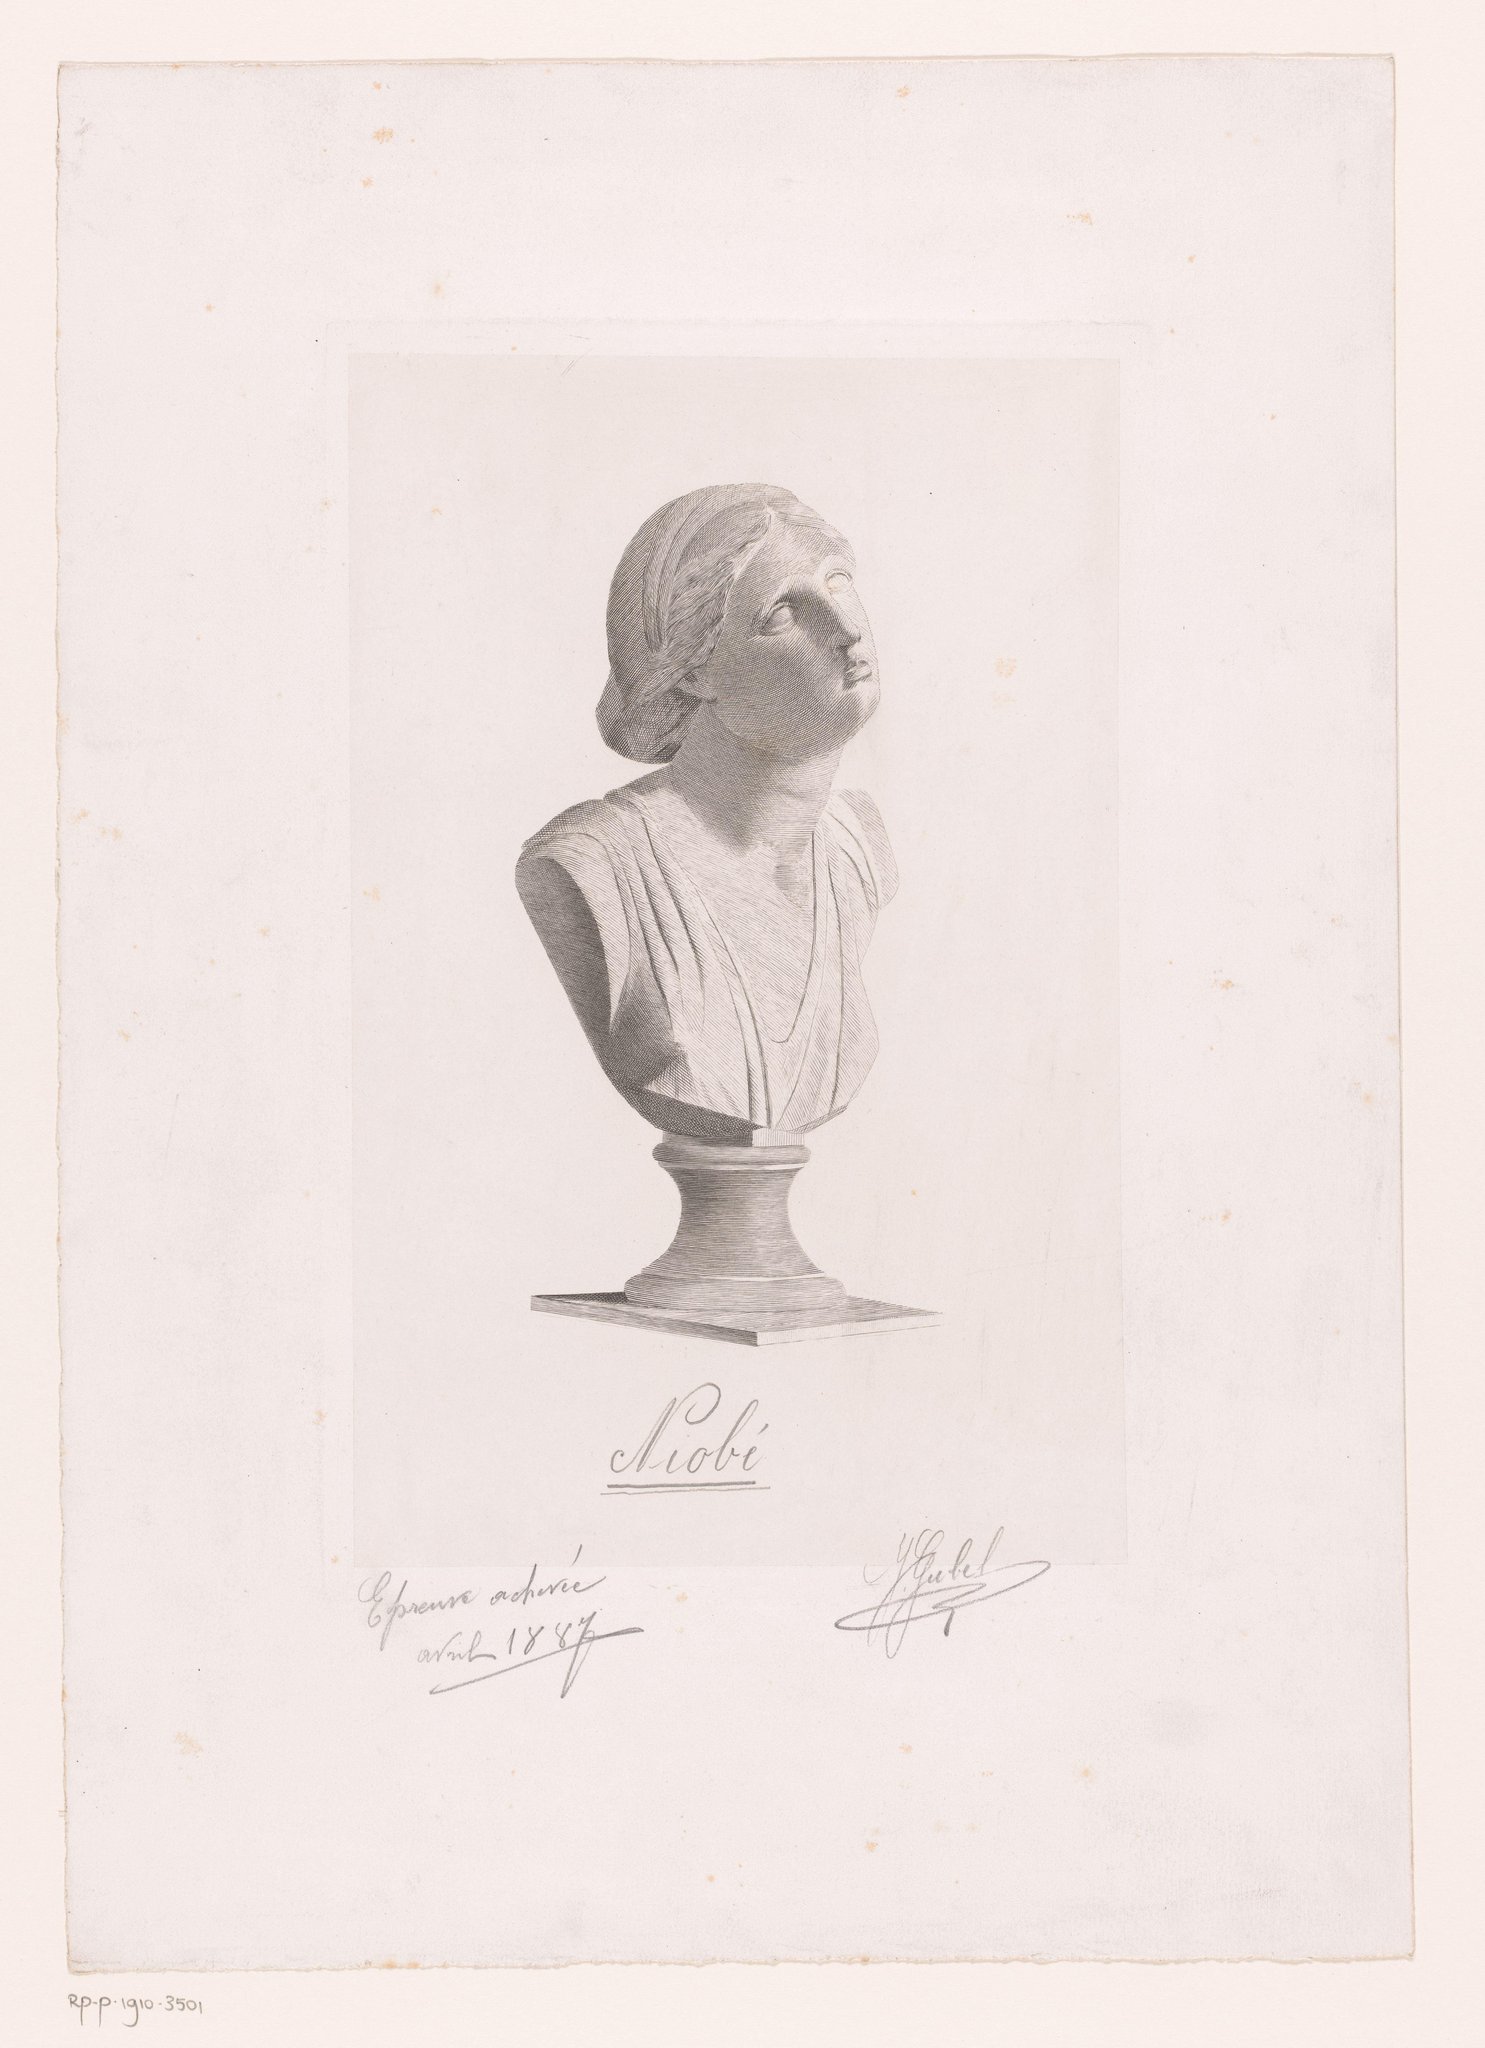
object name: print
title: Niobé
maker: j. gubel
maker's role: print maker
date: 1804-1887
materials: paper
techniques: etching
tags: (story of) niobe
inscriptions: collector's mark: Lugt 2228, annotation: ‘Epreuve achevée’